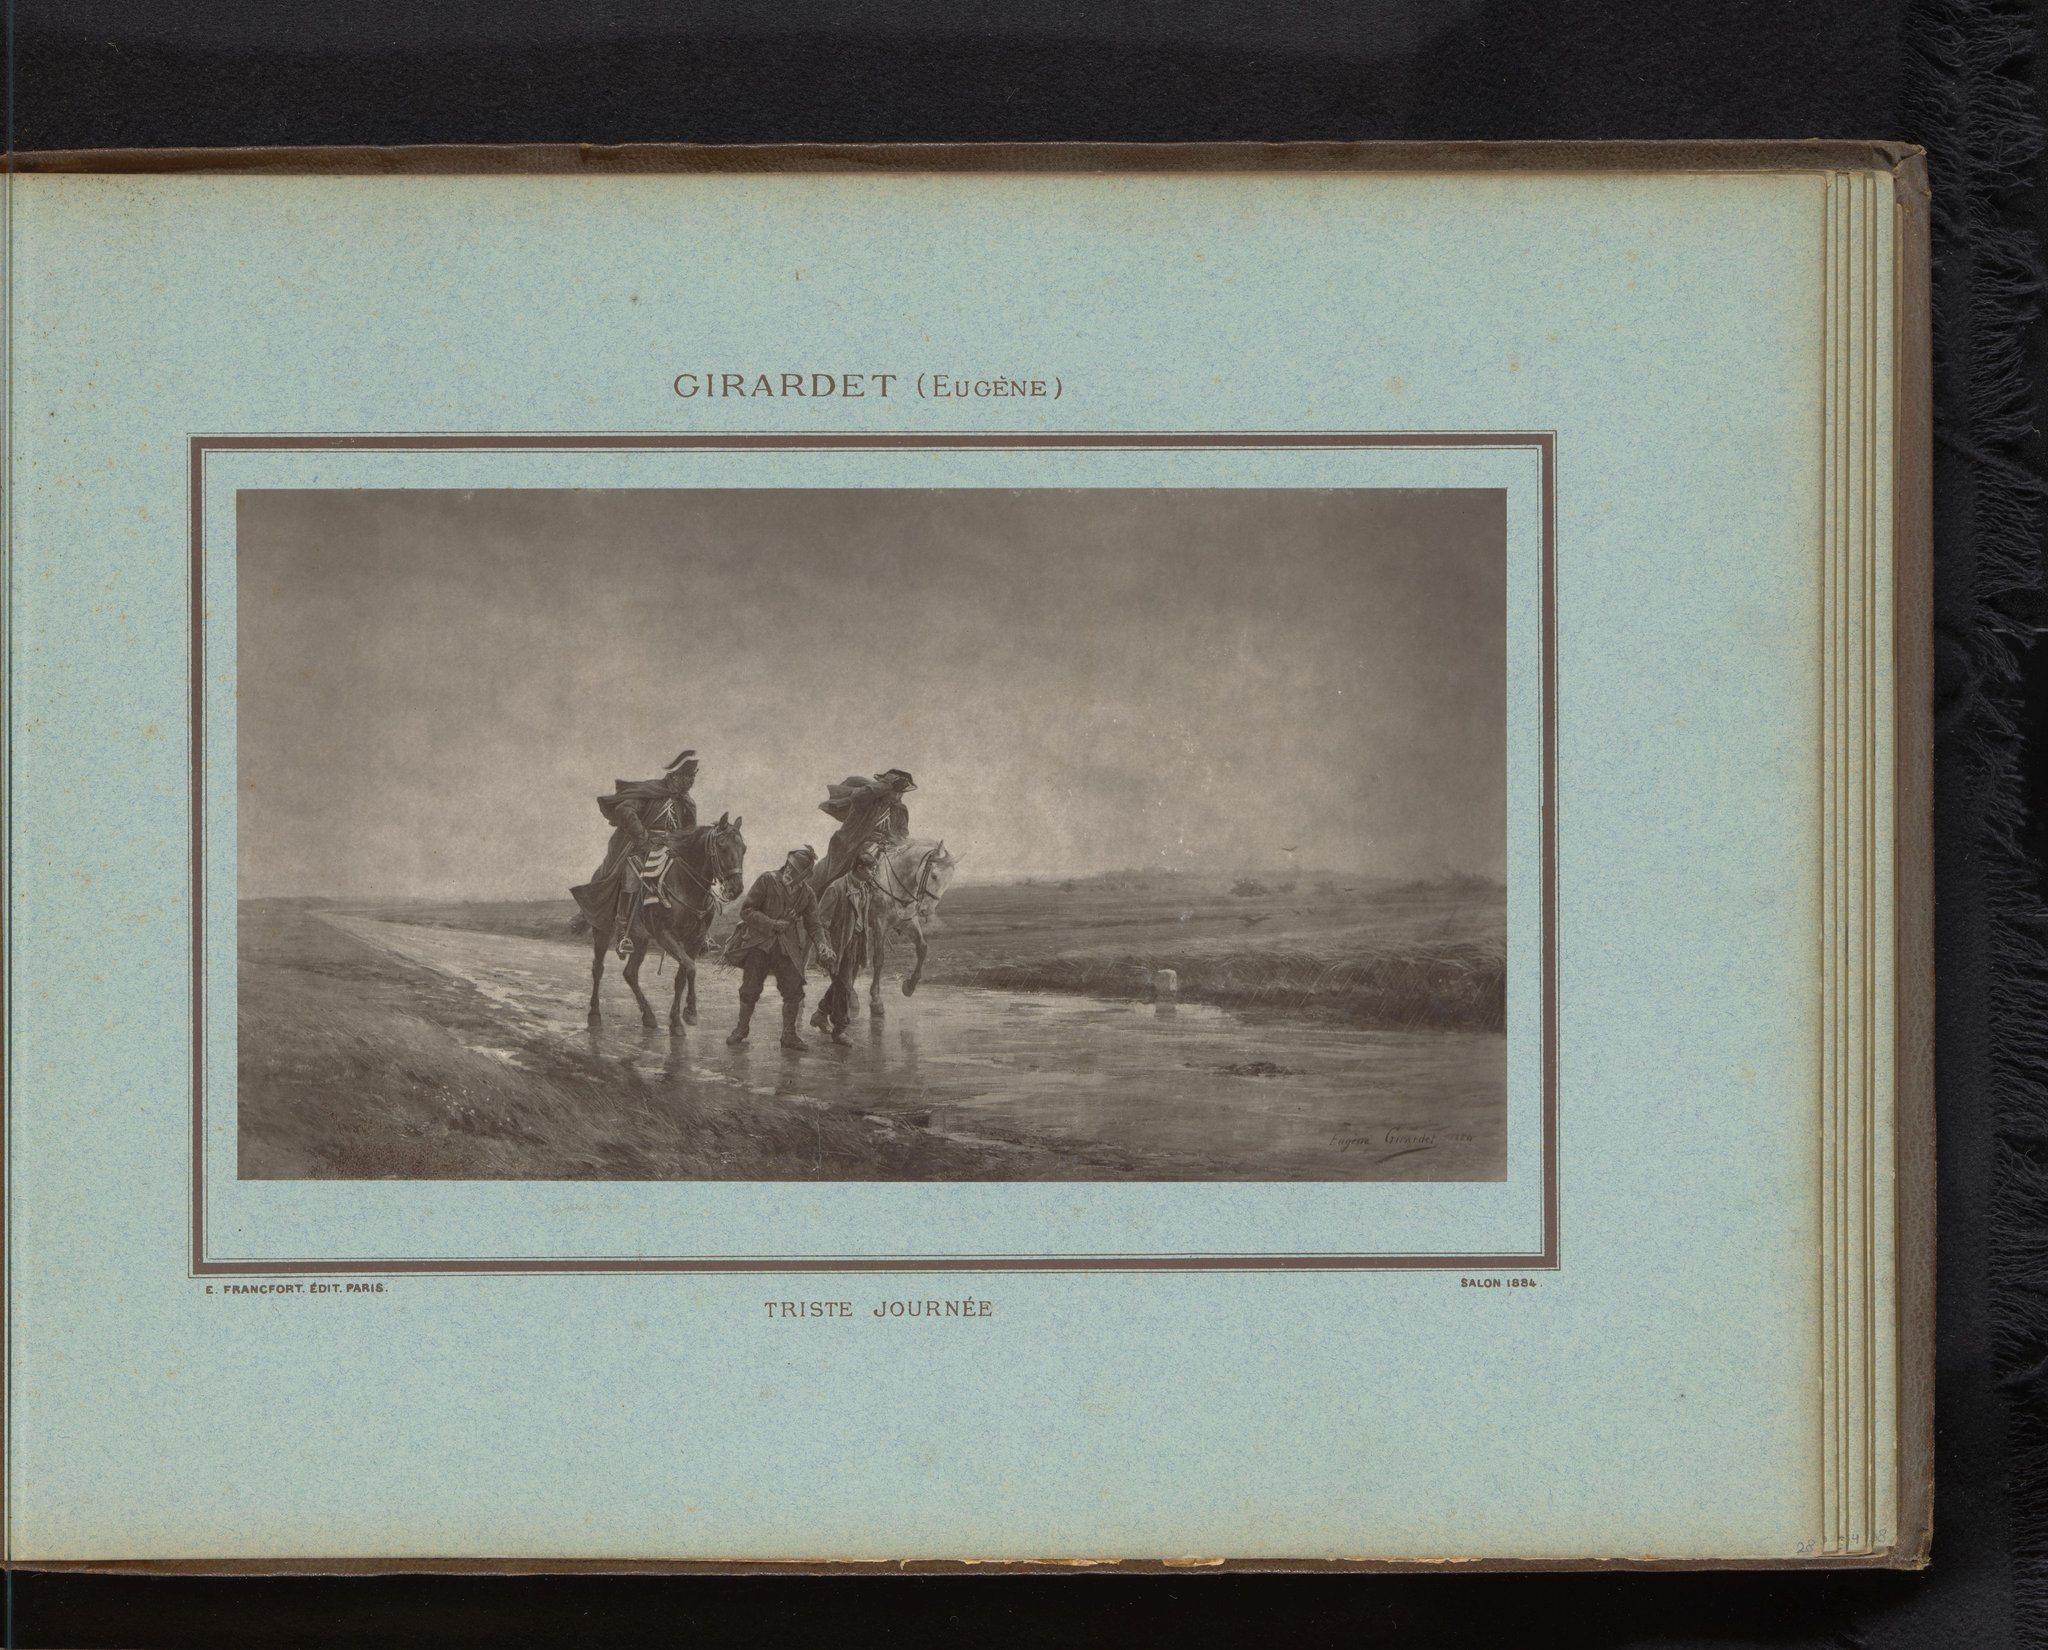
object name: photomechanical print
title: Reproductie van een schilderij van twee ruiters te paard en twee begeleiders door Eugène Alexis Girardet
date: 1884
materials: paper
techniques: woodburytype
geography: paris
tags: orphanage, farm (building)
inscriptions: name: ‘GIRARDET (Eugène)’, inscription: ‘SALON 1884.’